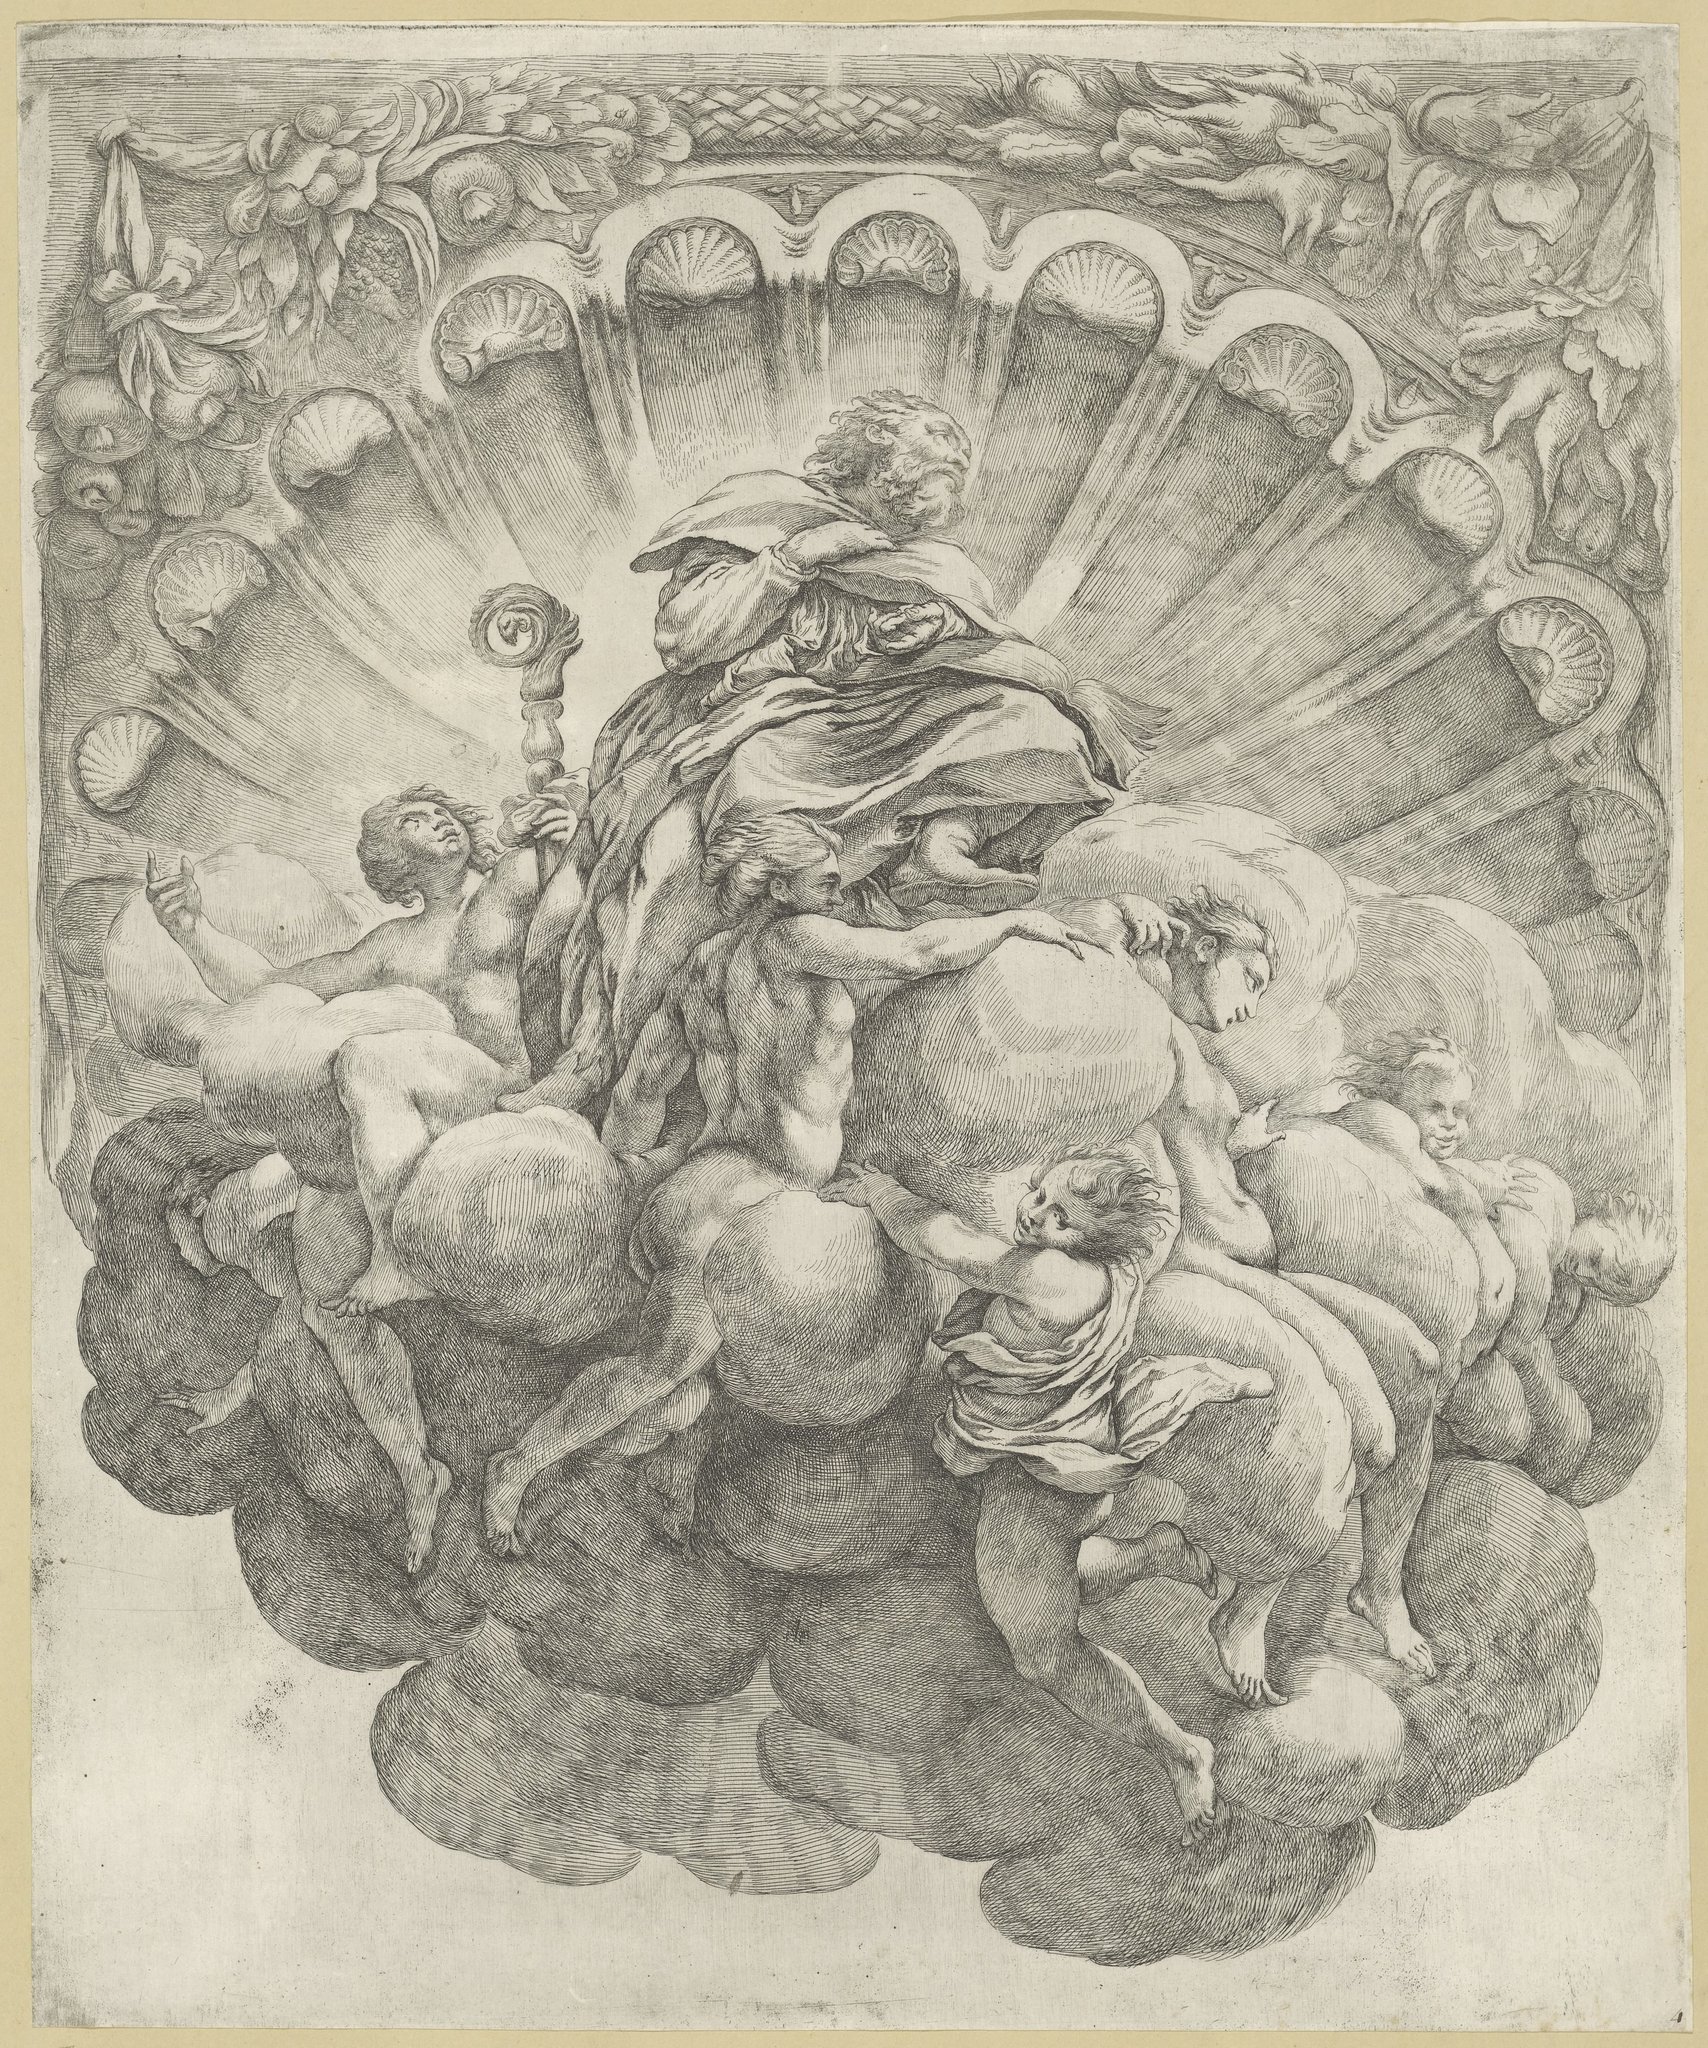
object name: print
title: Bisschop omgeven door zeven engelen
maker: giovanni battista vanni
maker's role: print maker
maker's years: 1599-1660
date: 1609-1660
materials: paper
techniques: etching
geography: parma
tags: archbishop, bishop, etc. (roman catholic), angels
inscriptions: collector's mark: Lugt 10, number: ‘1’, collector's mark: Lugt 11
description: Prent uit een reeks van 4 prenten naar de koepeldecoraties door Correggio in de S. Giovanni Evangelista in Parma.